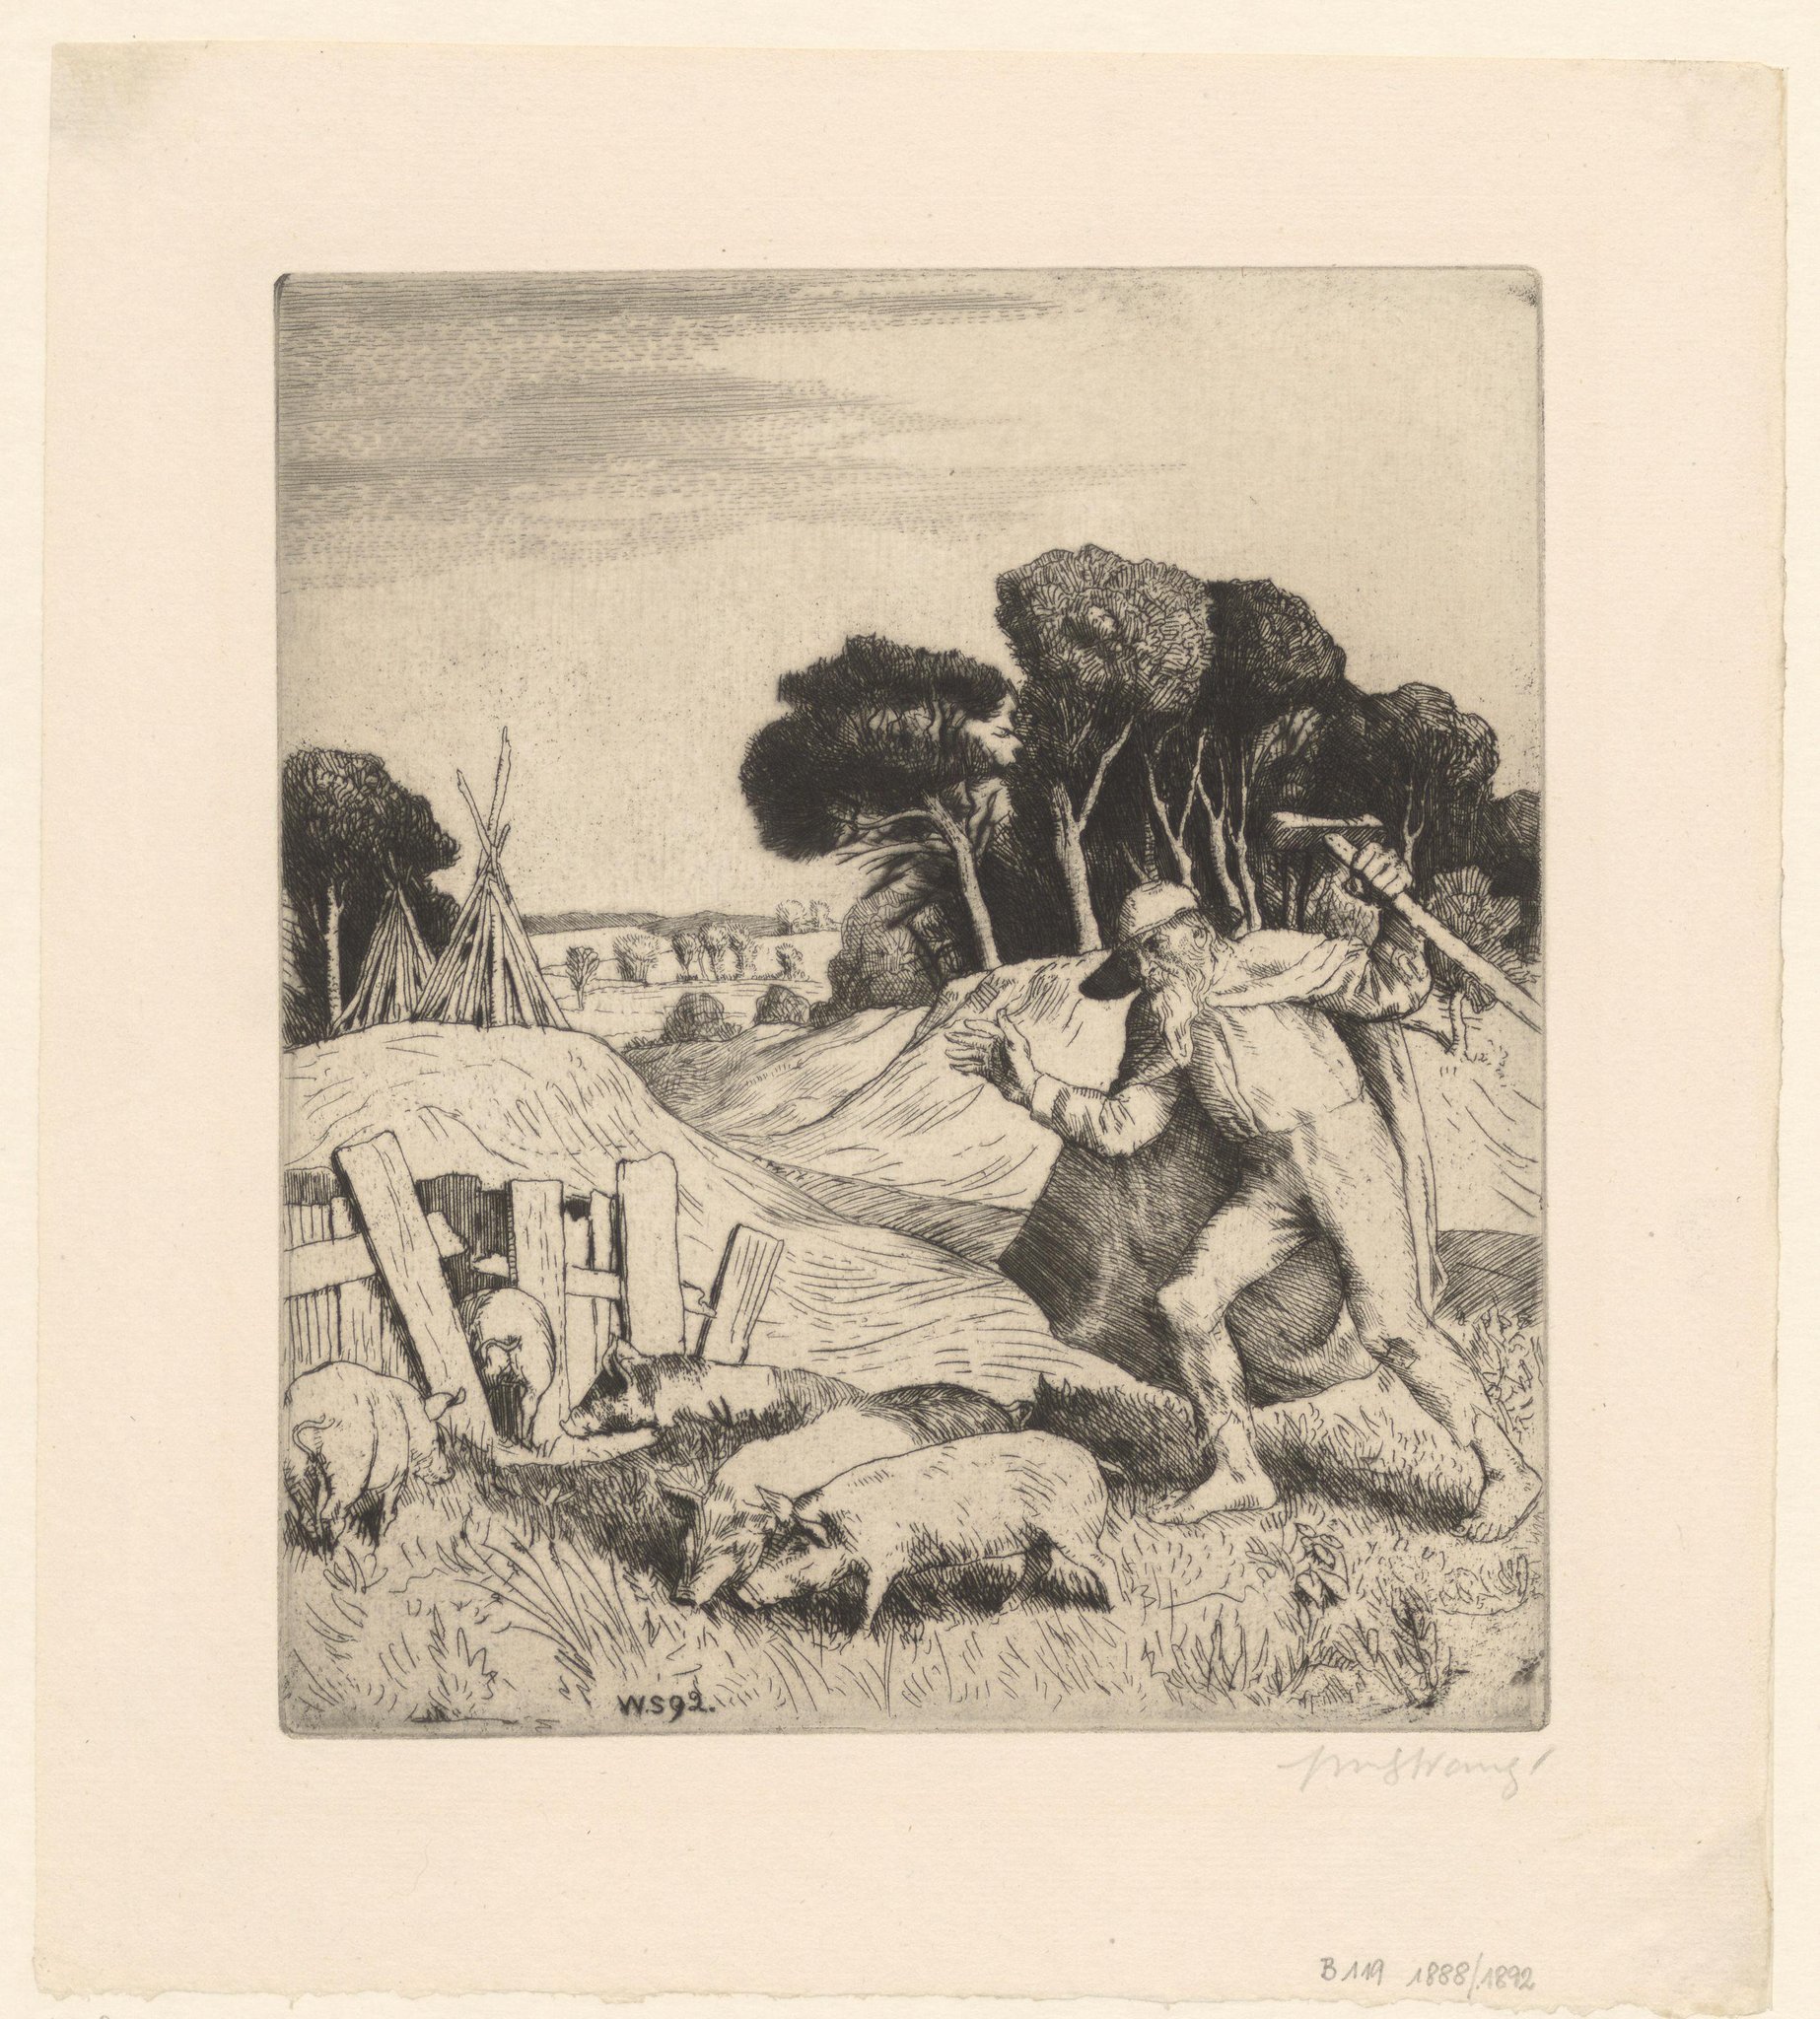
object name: print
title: Death and the Ploughmans wife: a ballad made & etched by William Strang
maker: william strang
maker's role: print maker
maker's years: 1859-1921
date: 1892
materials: paper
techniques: etching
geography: london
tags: pig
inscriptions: signature: ‘WmStrang’